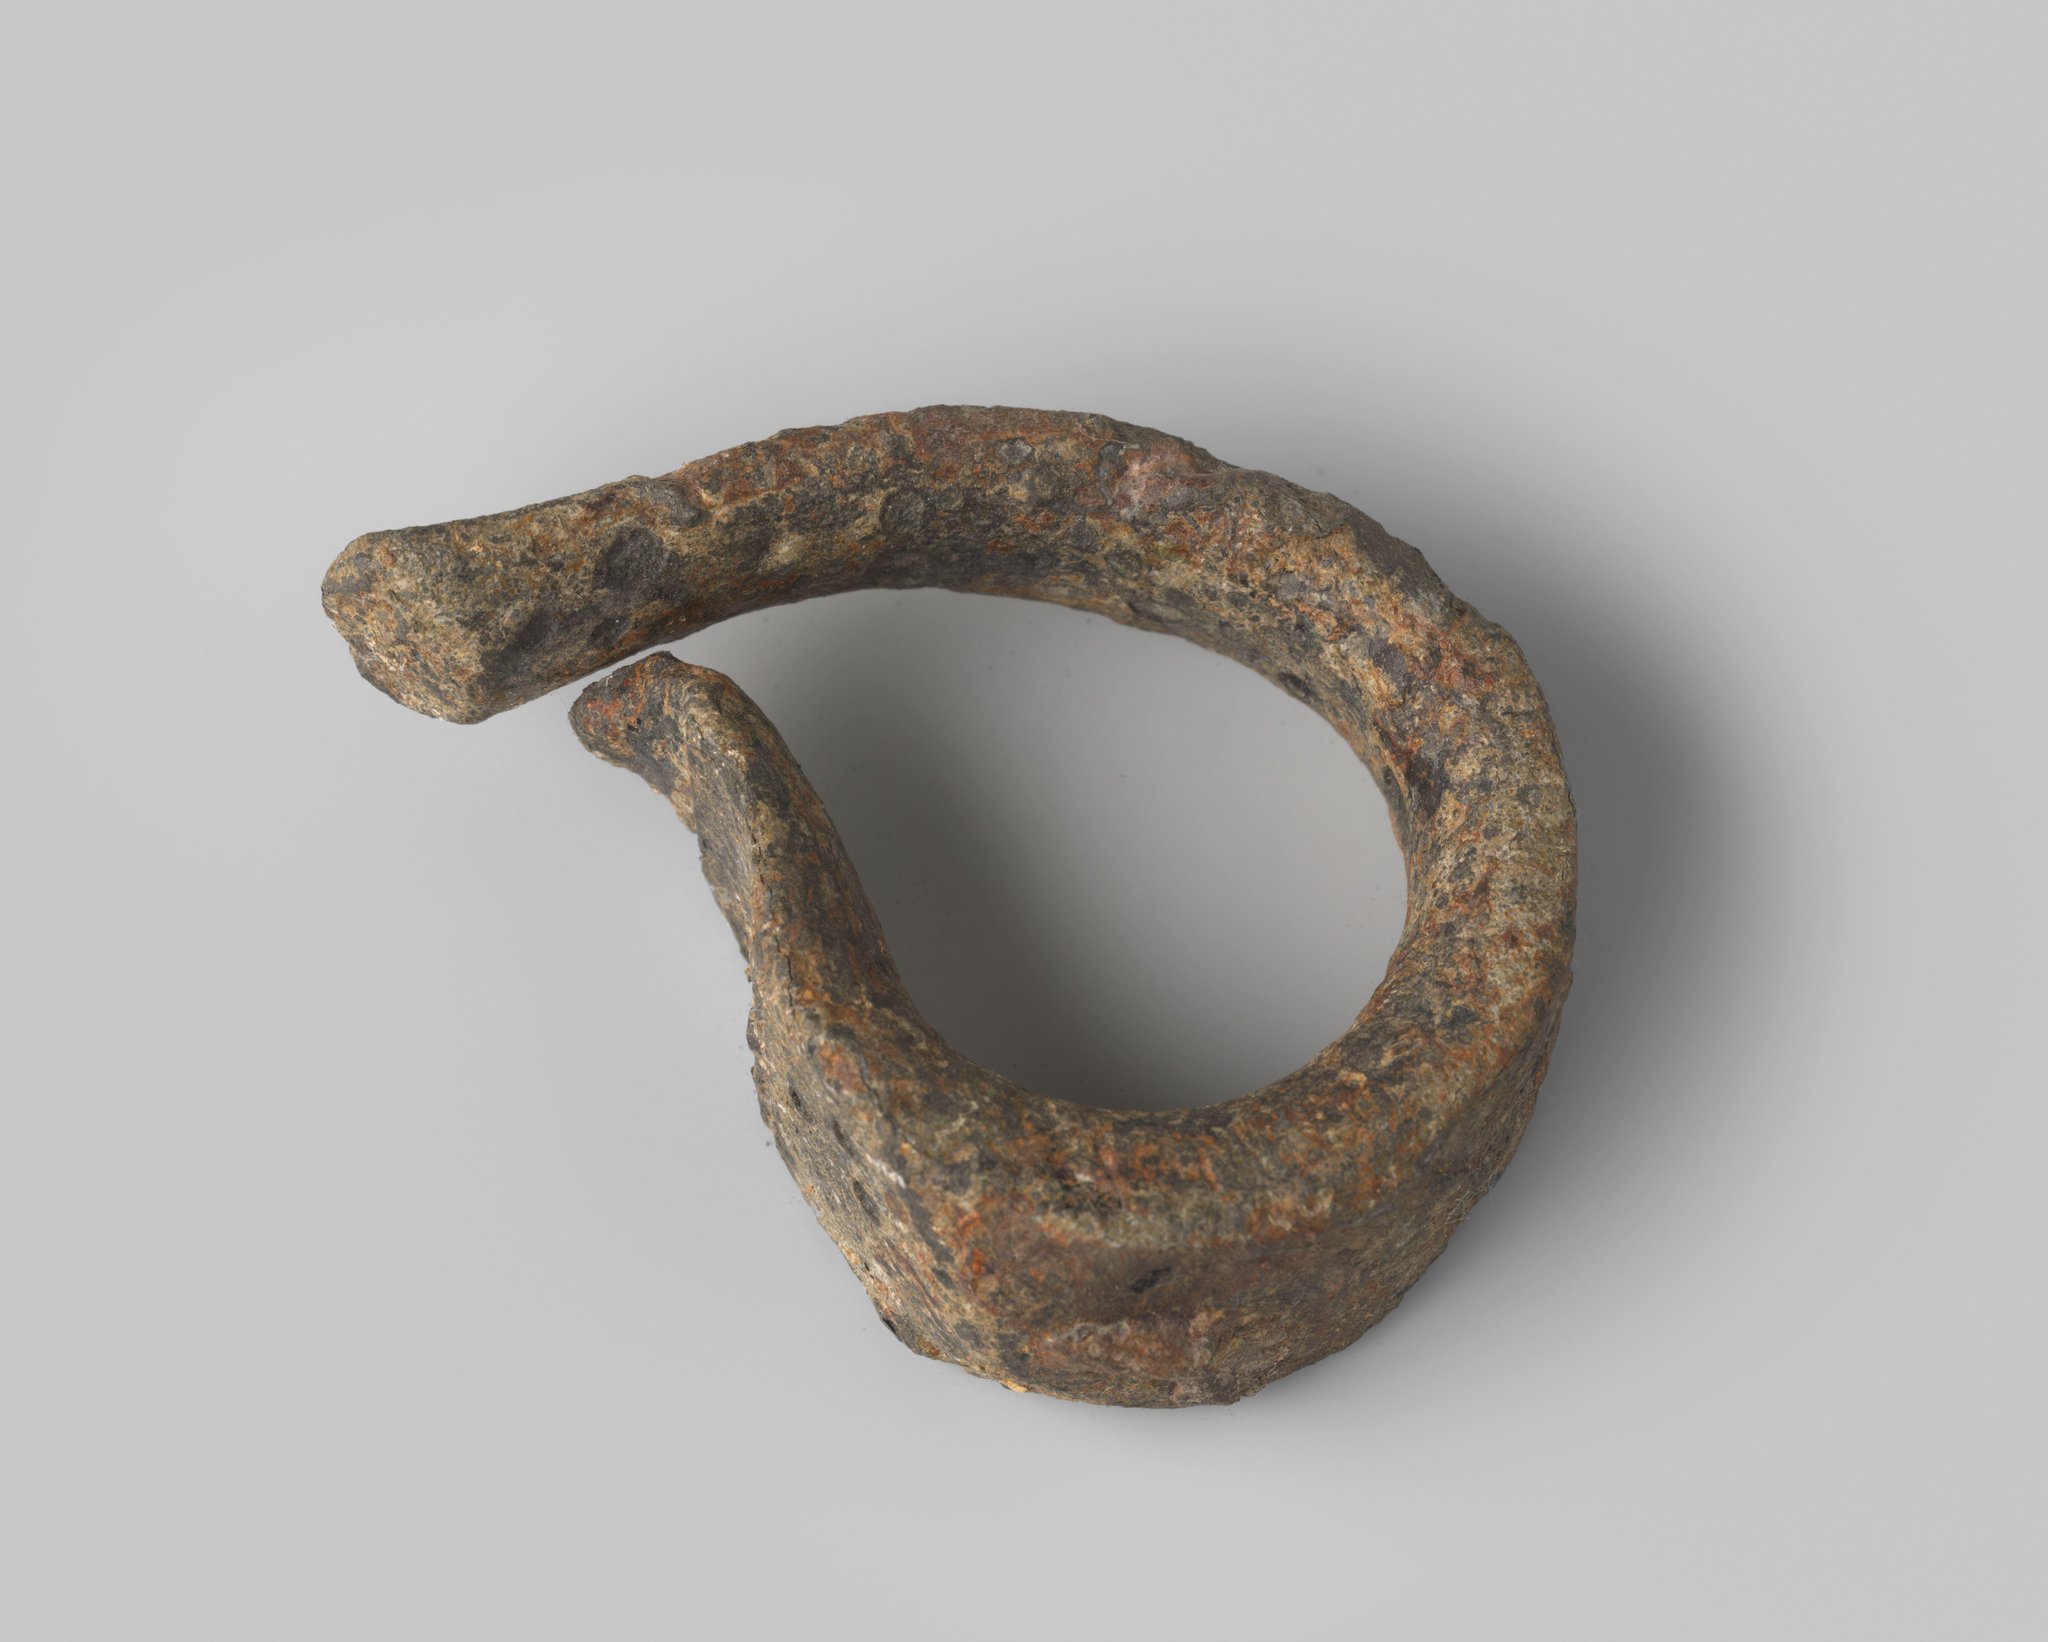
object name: ewer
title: Oor van een kan uit het wrak van de Oost-Indiëvaarder Hollandia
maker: Anonymous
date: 1700-1743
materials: lead, tin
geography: netherlands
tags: verenigde oostindische compagnie, hollandia (schip), annet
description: Jug, handle, bent; looped strip, semicircular in section, tapering, straight lower end with bevelled edge.